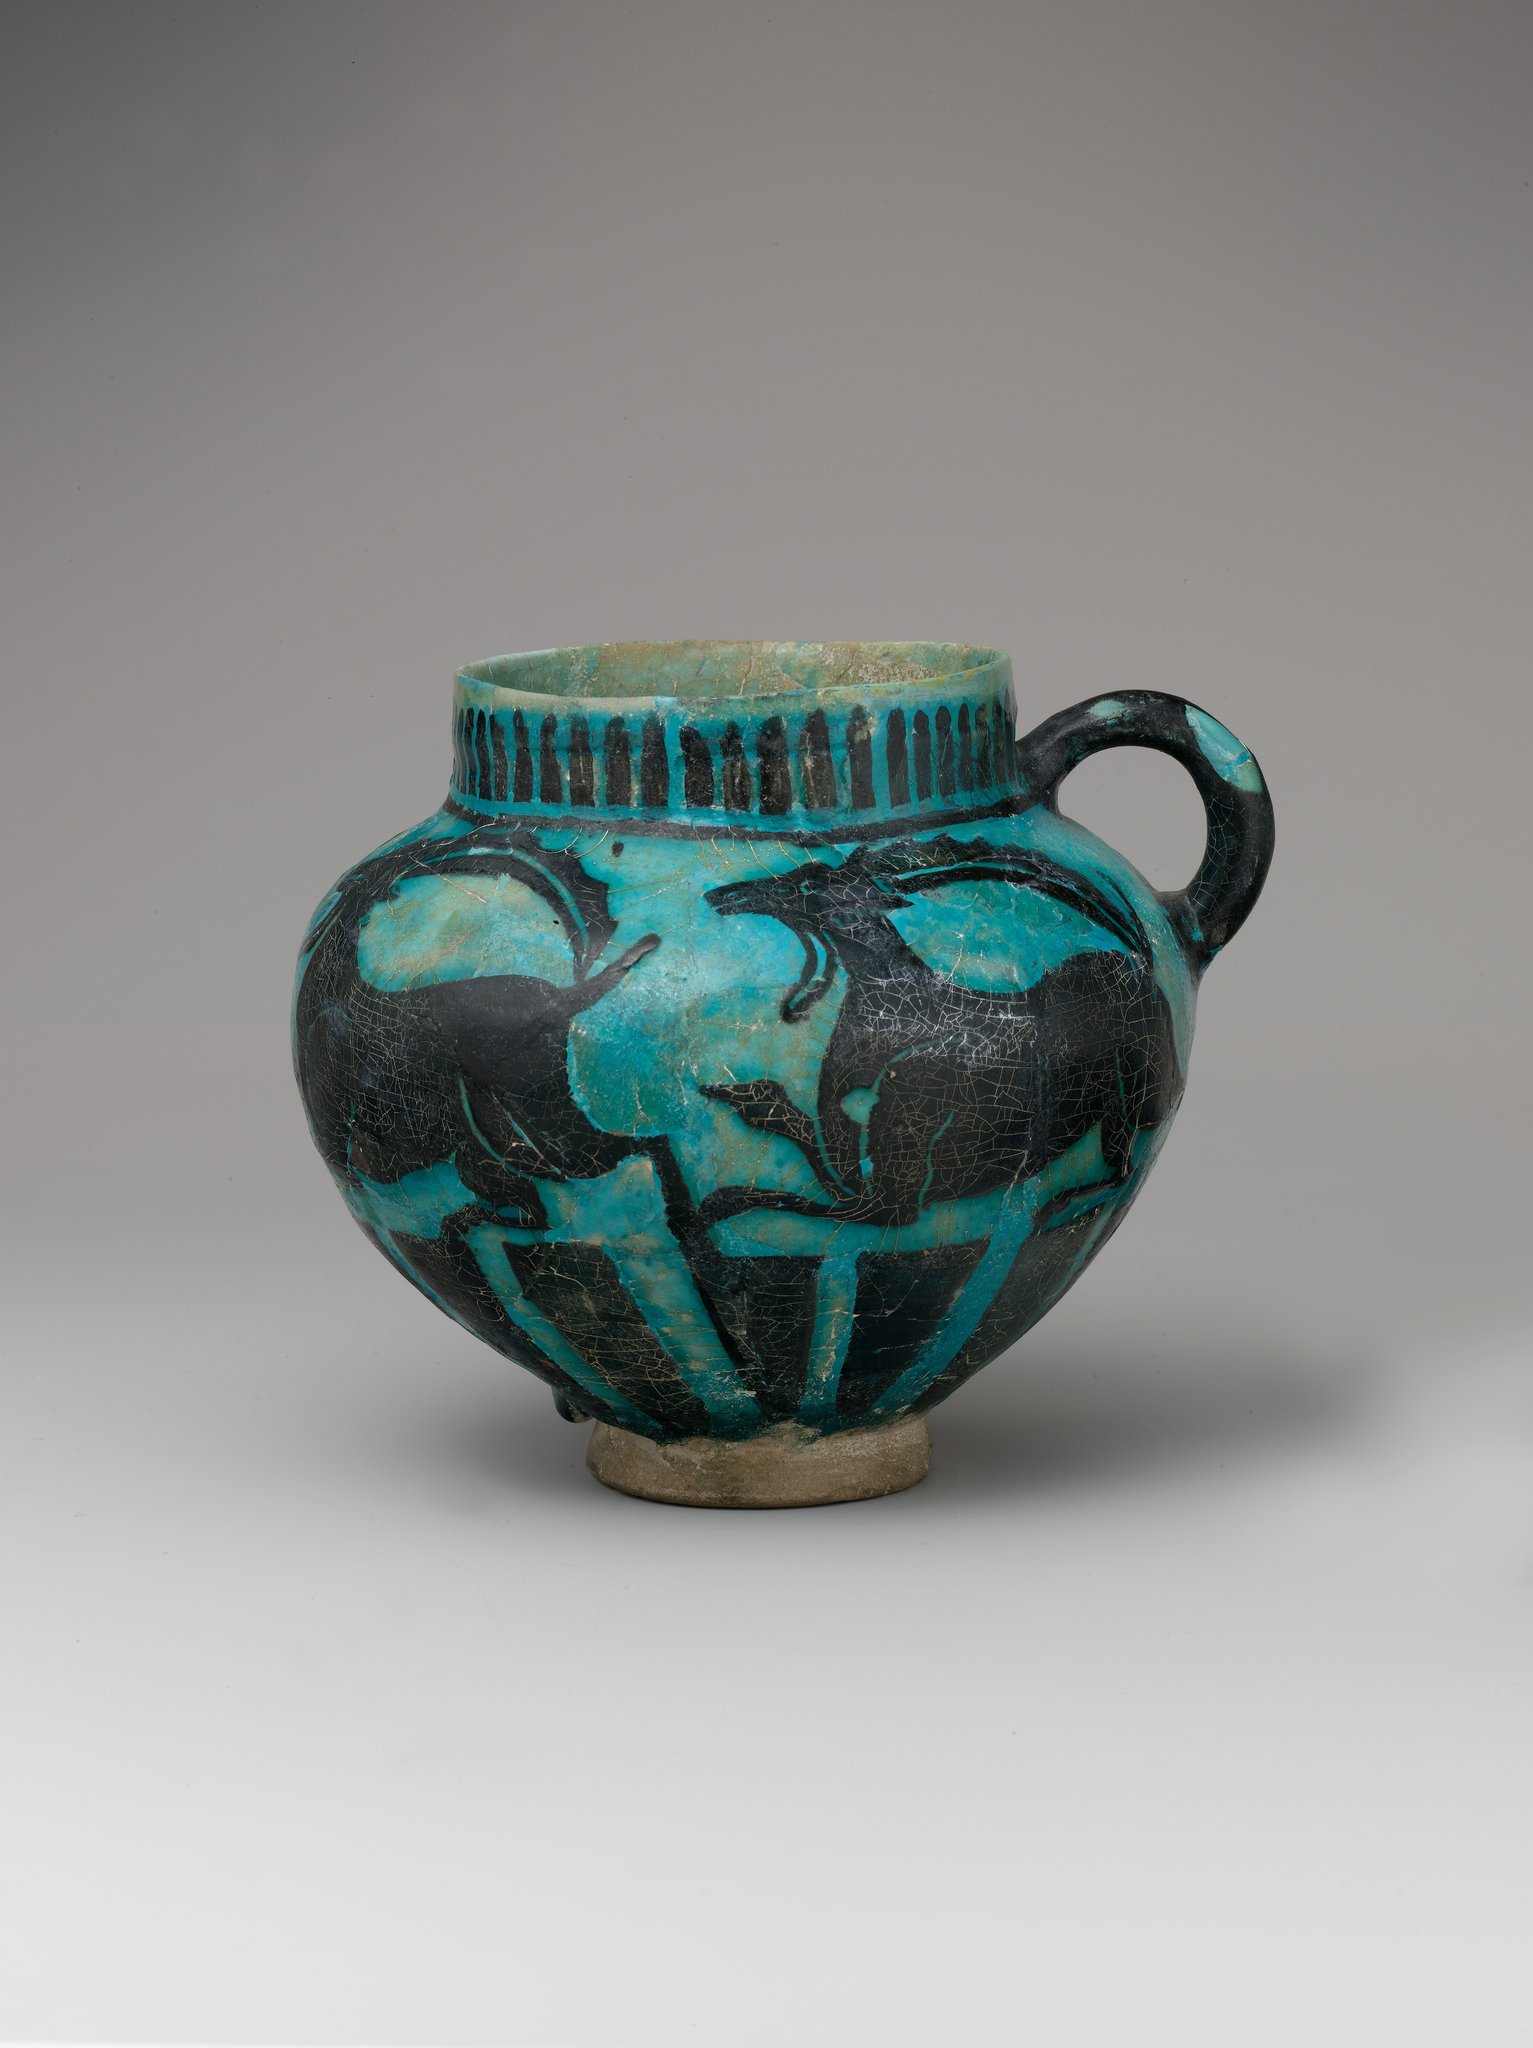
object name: cup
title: Cup with Running Ibexes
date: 1151-1200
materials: glaze, stonepaste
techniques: incising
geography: iran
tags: ibex